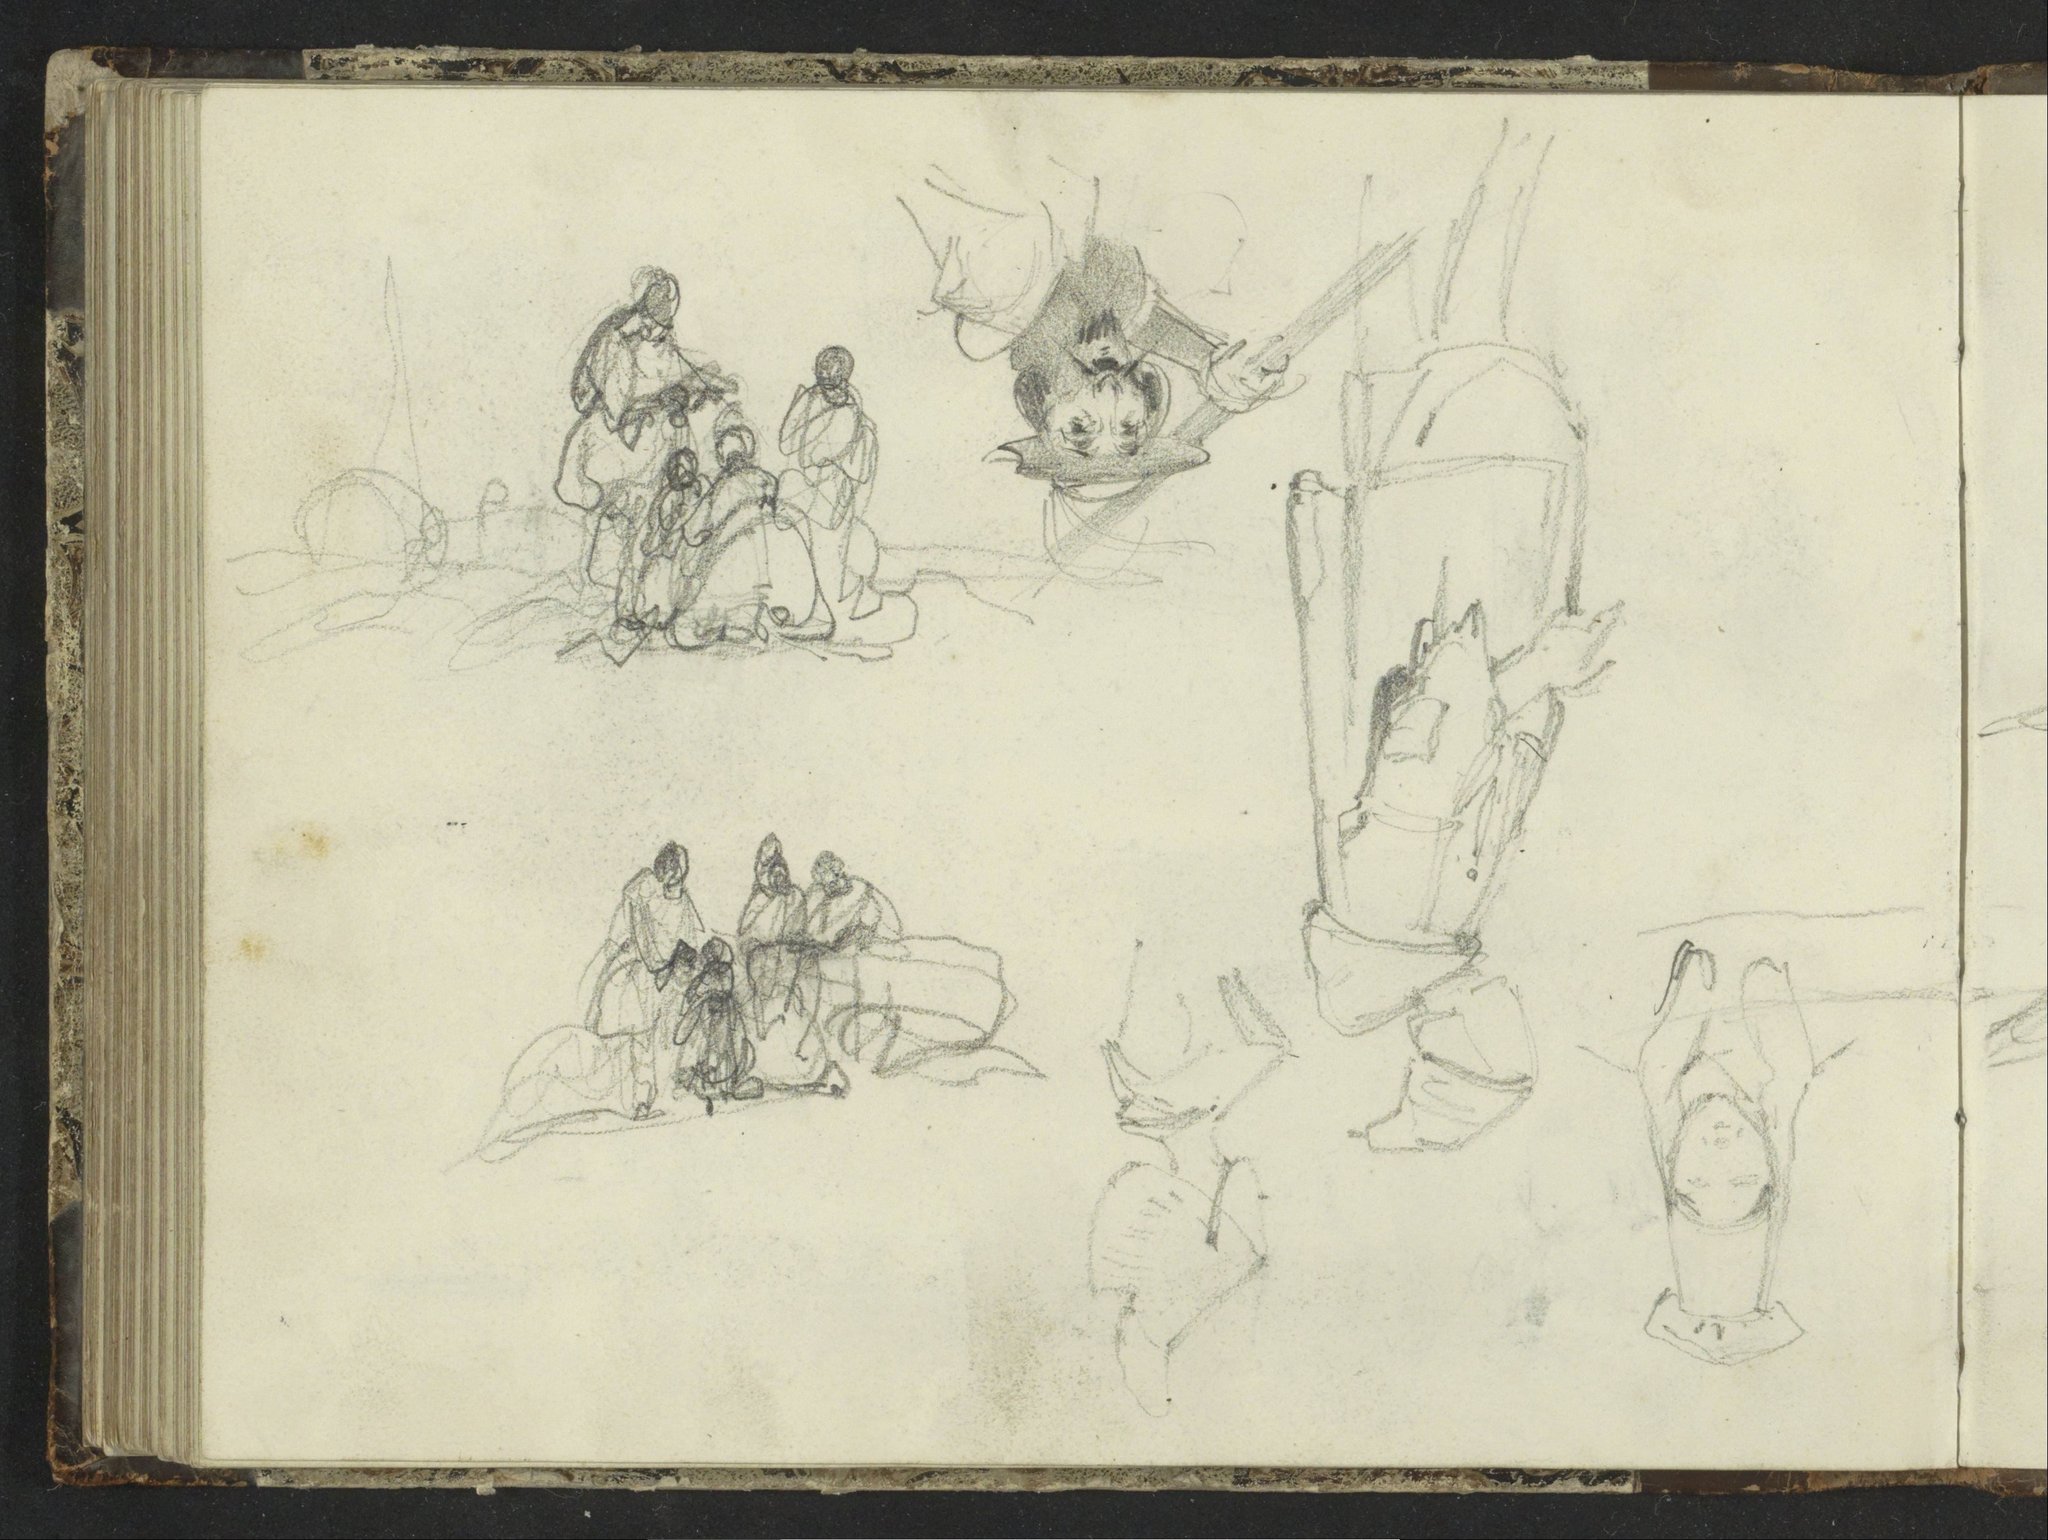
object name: sketchbook leaf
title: Studieblad met figuren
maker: willem hendrik schmidt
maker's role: draughtsman, painter, print maker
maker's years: 1809-1849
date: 1819-1849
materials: paper, pencil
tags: head-gear: cap (+ women's clothes), beach (+ landscape with figures, staffage)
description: Onder andere studies van figuren op een strand, een man met een stok en vrouwen met mutsen. Blad 57 verso uit een schetsboek met 58 bladen.